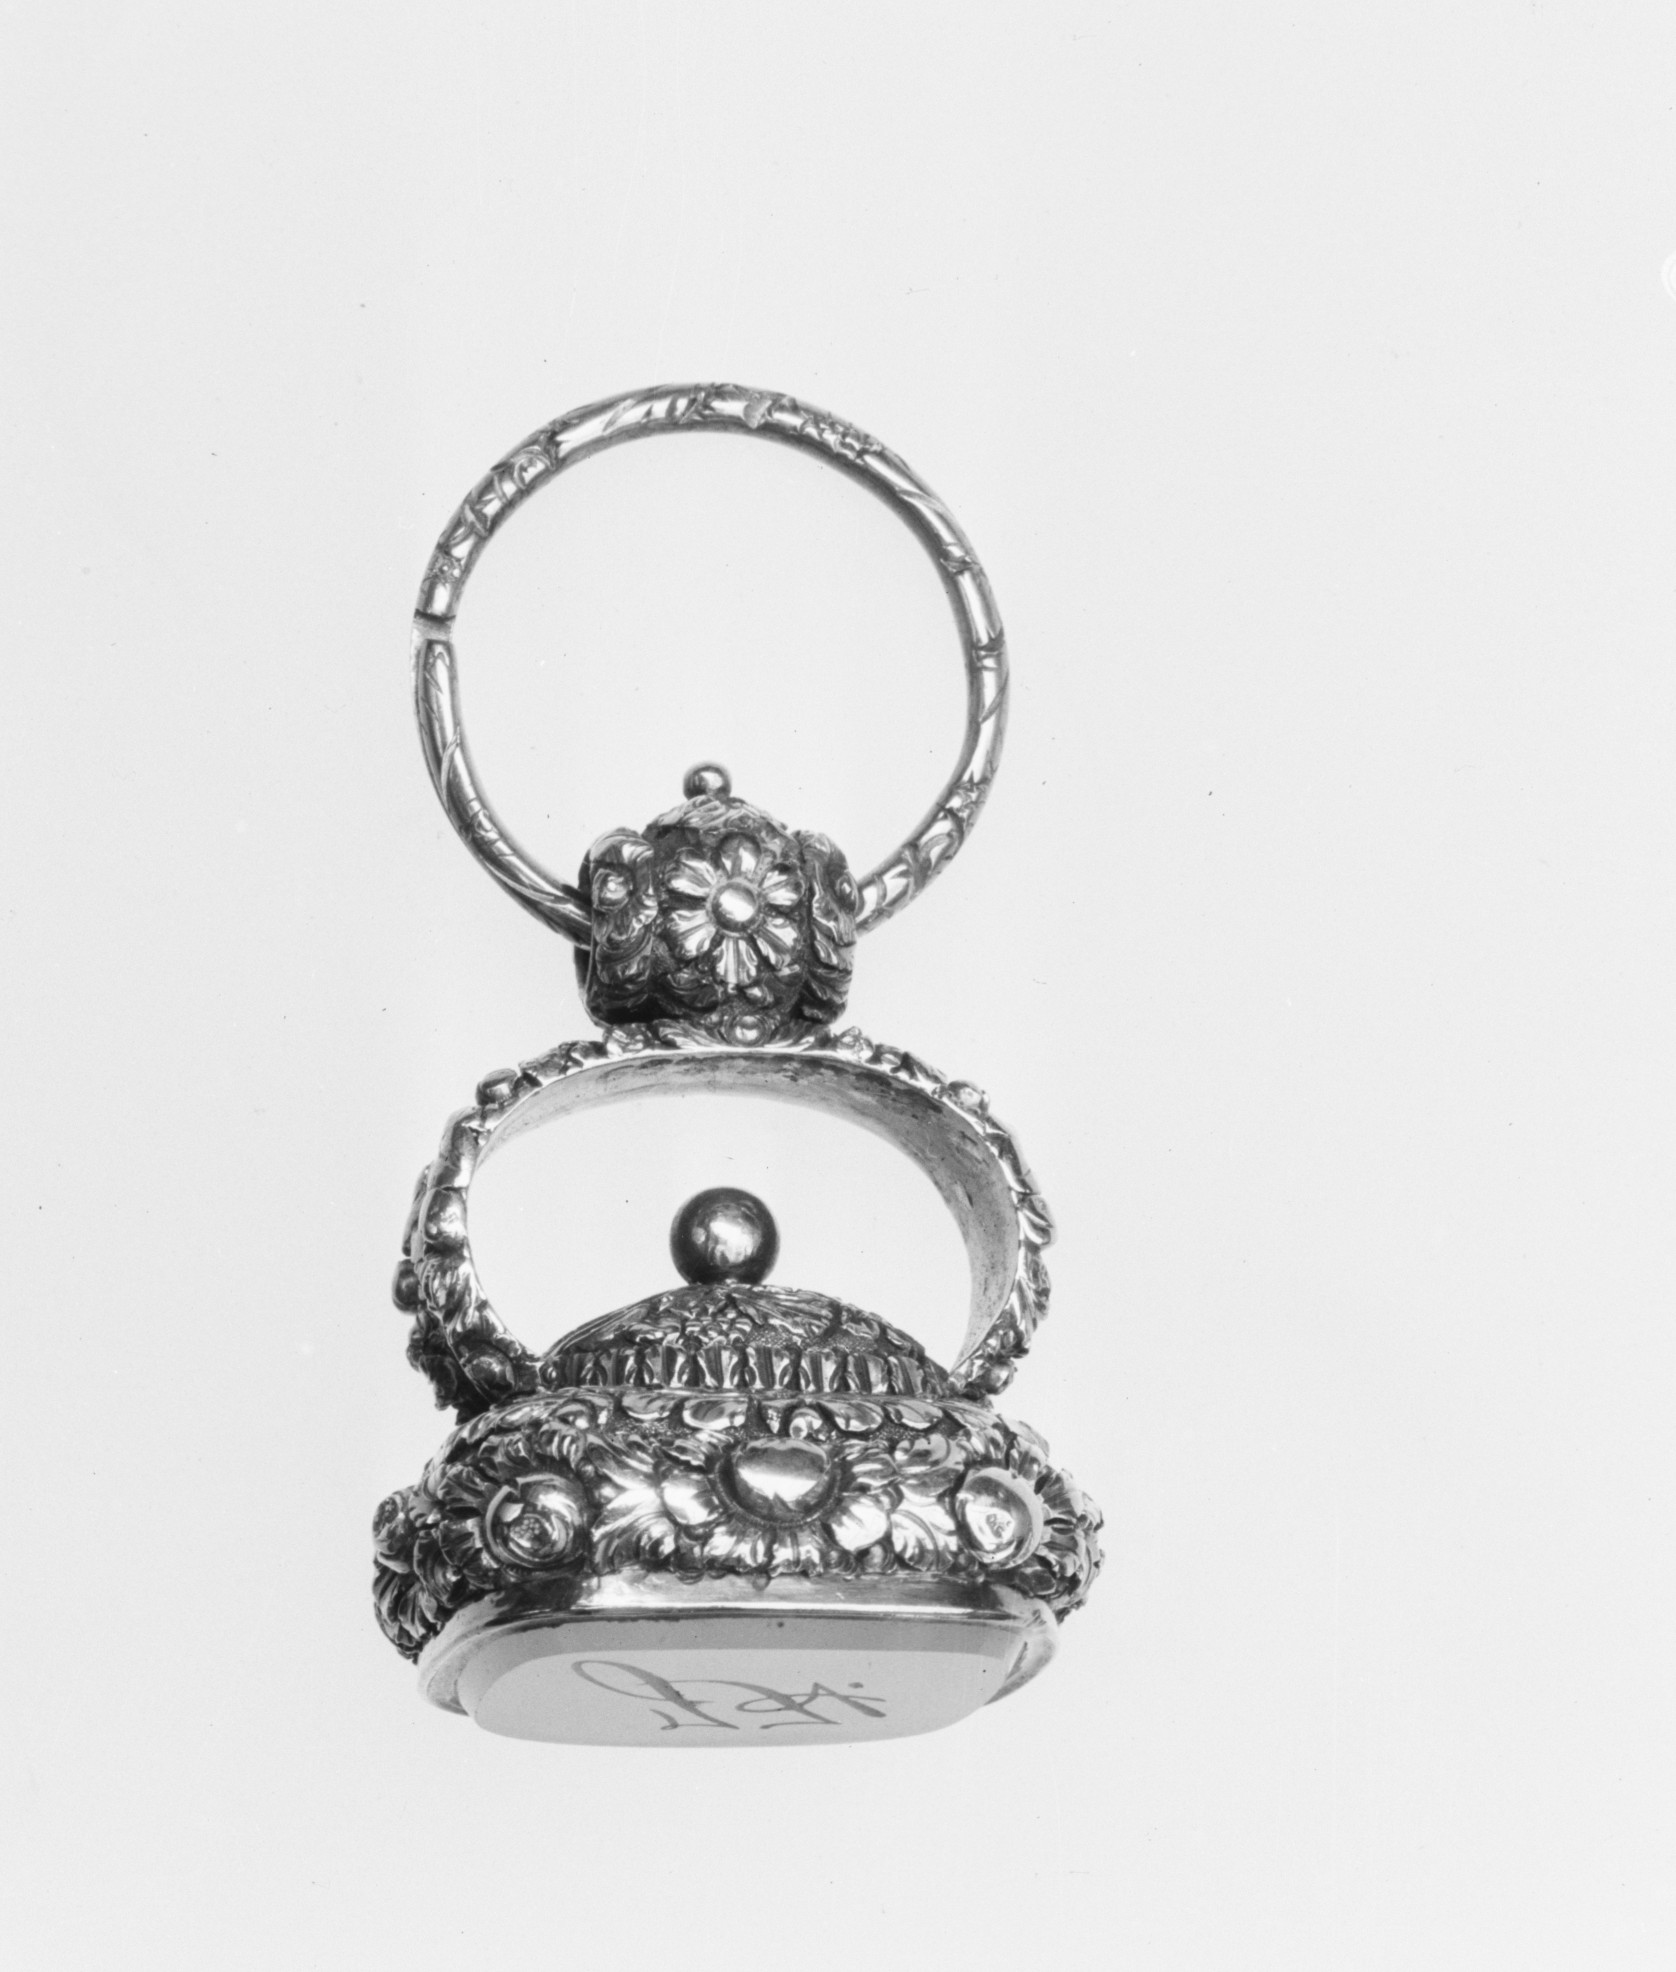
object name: seal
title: Fob seal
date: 1801-1900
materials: gold, onyx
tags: flowers,insignia